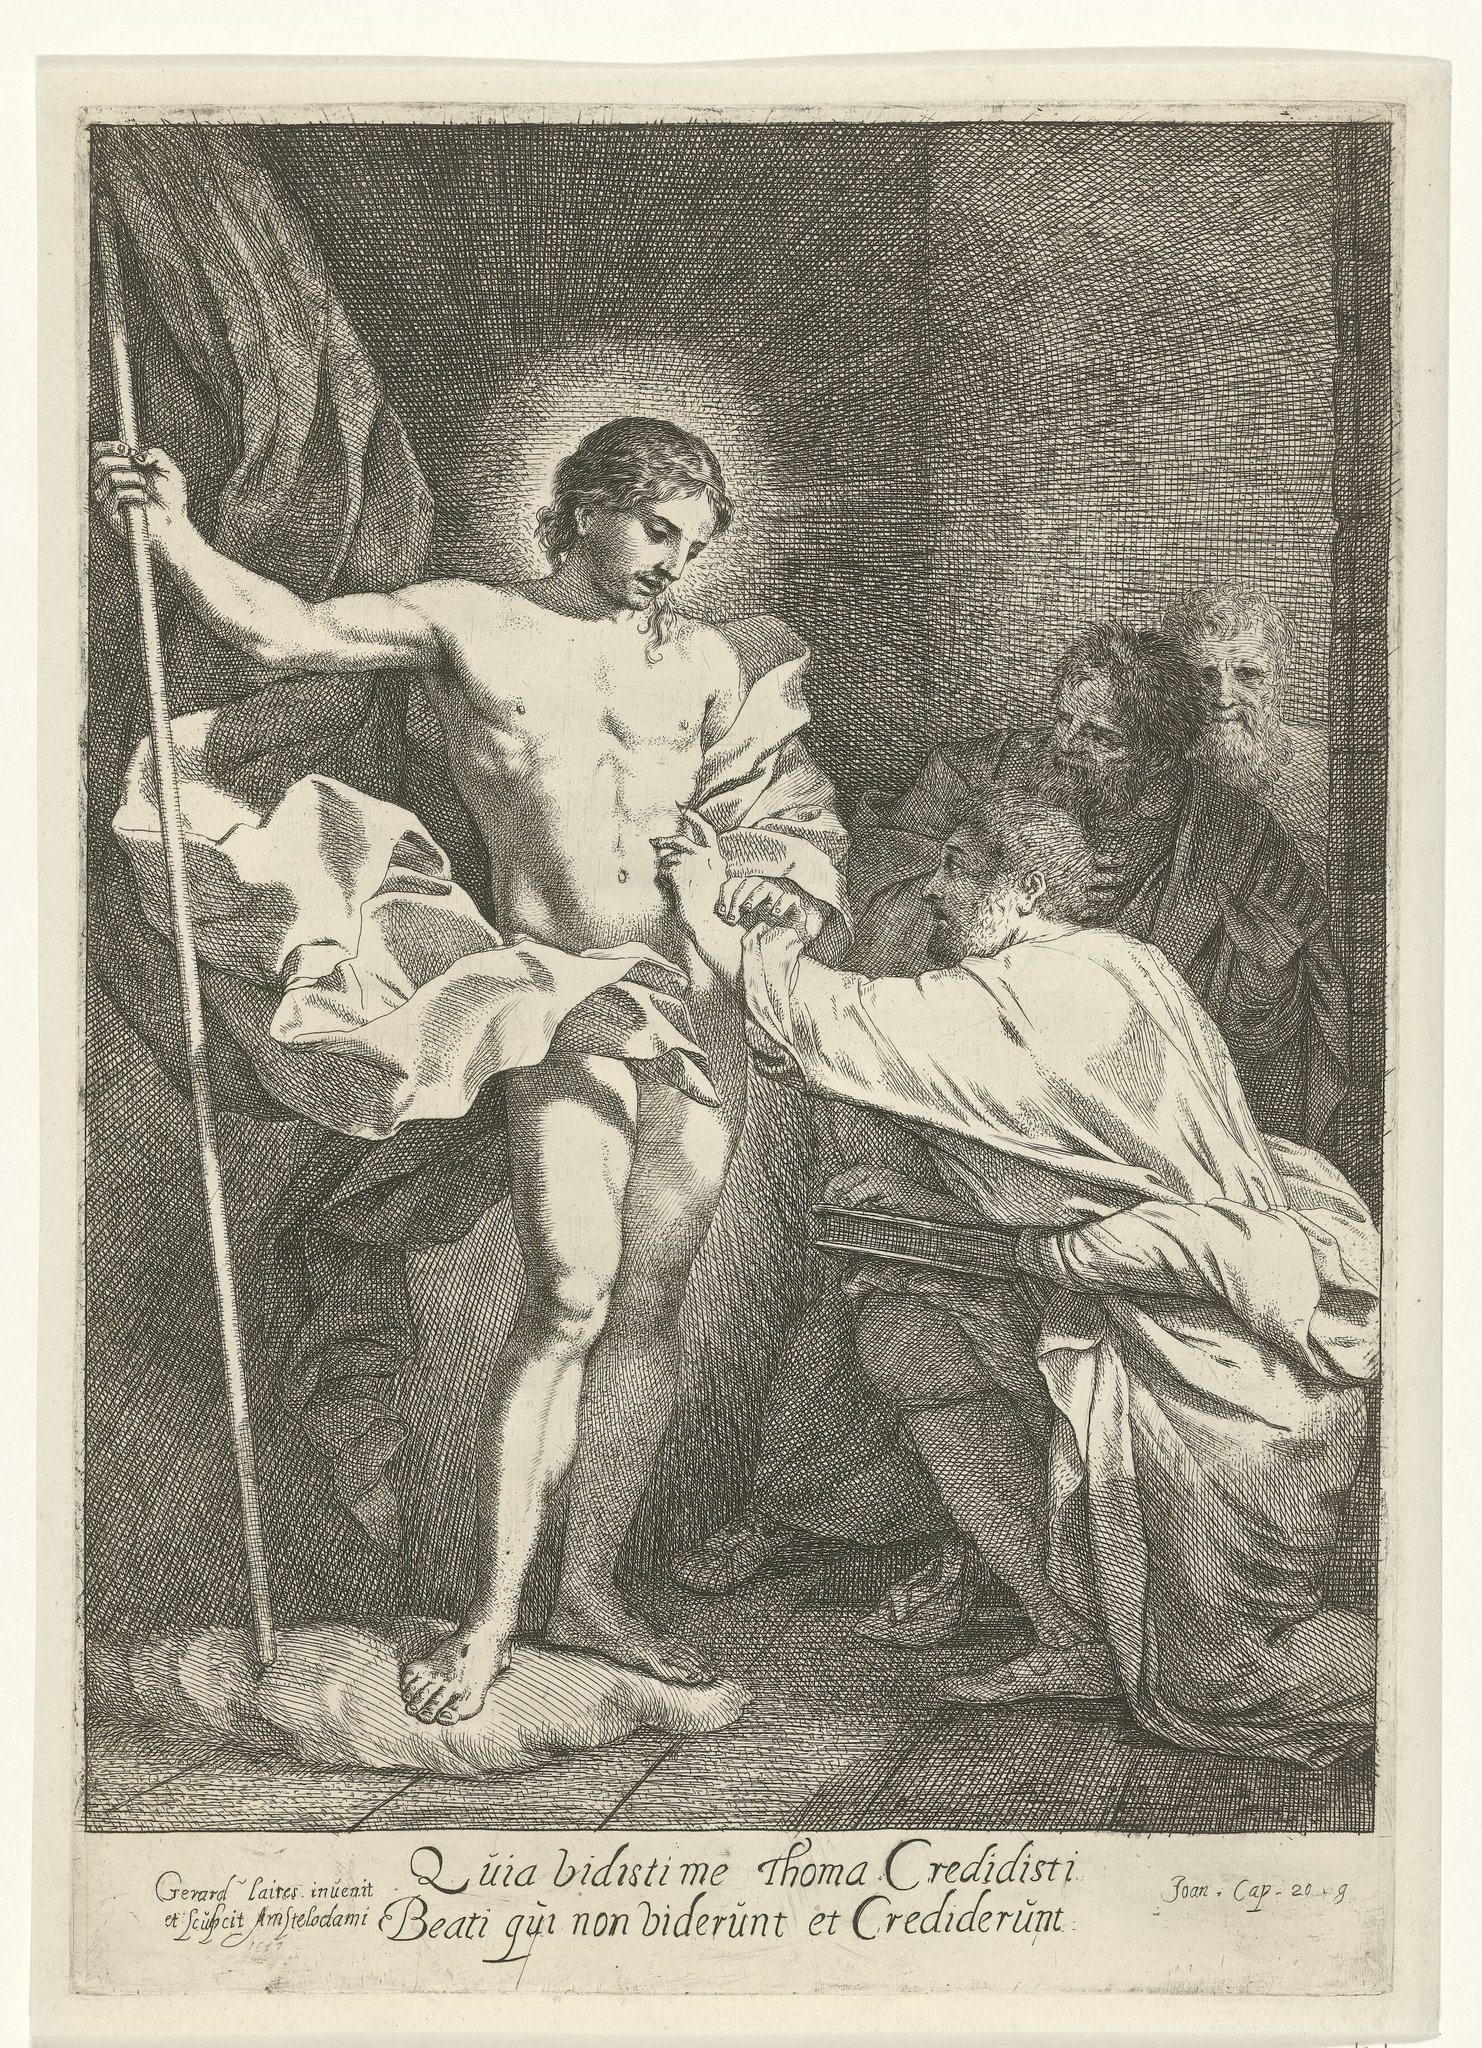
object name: print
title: Ongeloof van Tomas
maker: gerard de lairesse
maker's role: draughtsman, painter, print maker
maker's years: 1641-1711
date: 1670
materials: paper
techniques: etching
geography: amsterdam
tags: the incredulity of thomas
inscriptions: collector's mark: Lugt 240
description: Bijbelse voorstelling uit Joh. 20:24-31. Christus is aan de apostel Tomas verschenen en laat hem de wond in zijn zij aanraken. Tomas zit met een boek geknield voor Christus, op de achtergrond kijken twee andere apostelen verwonderd toe.